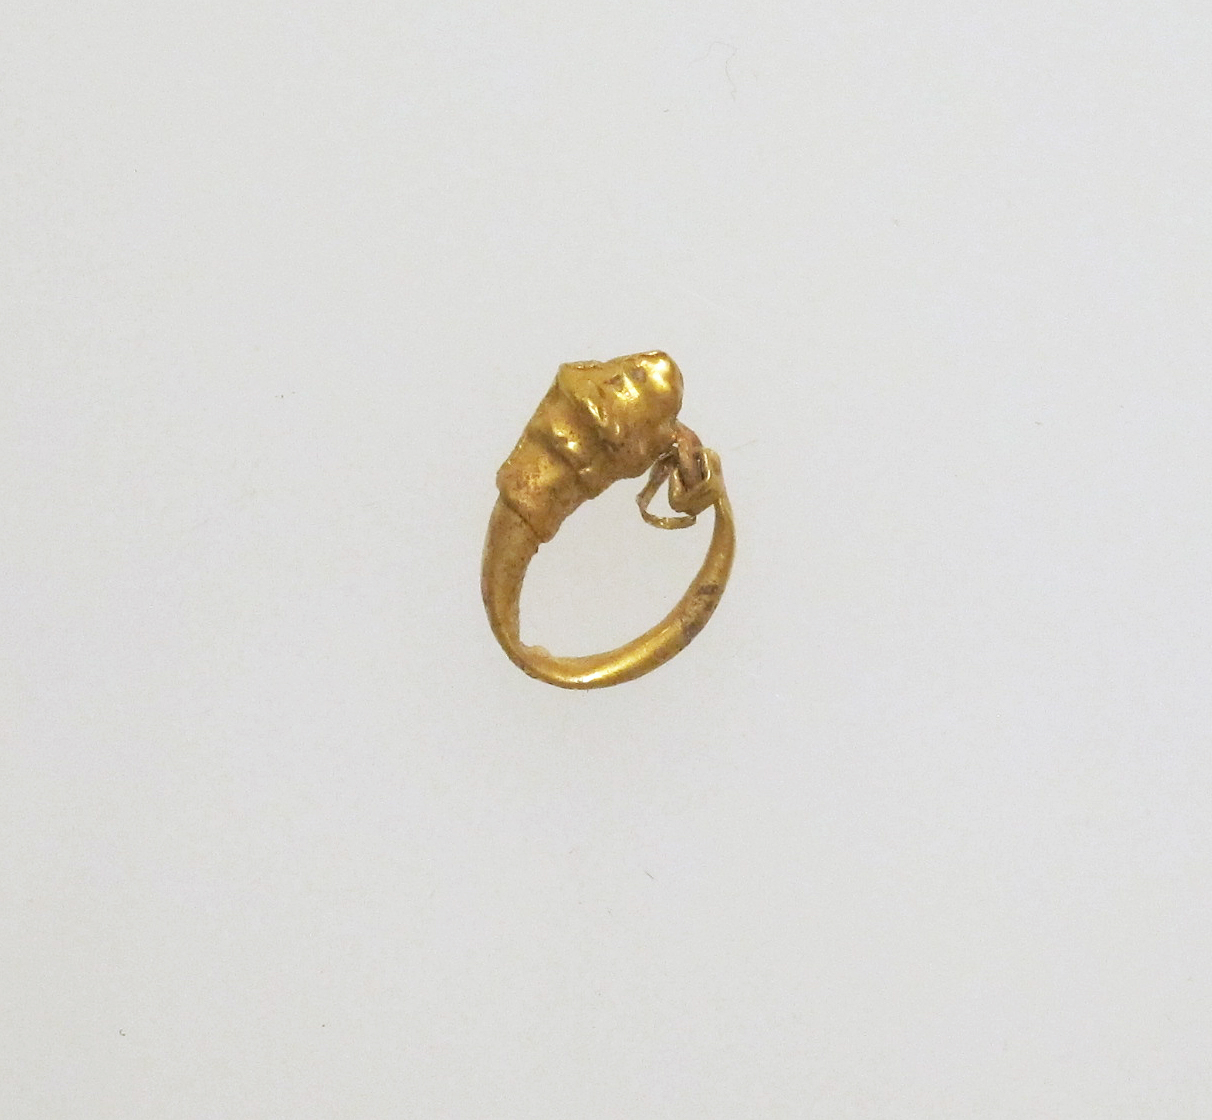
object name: earring with head of lion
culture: greek, south italian, tarentine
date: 7000-30 BCE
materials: gold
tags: lions